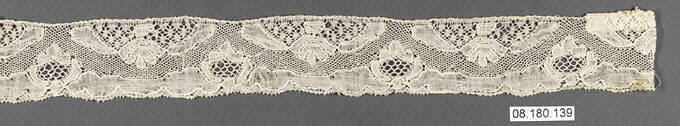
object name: fragment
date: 1701-1800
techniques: lace